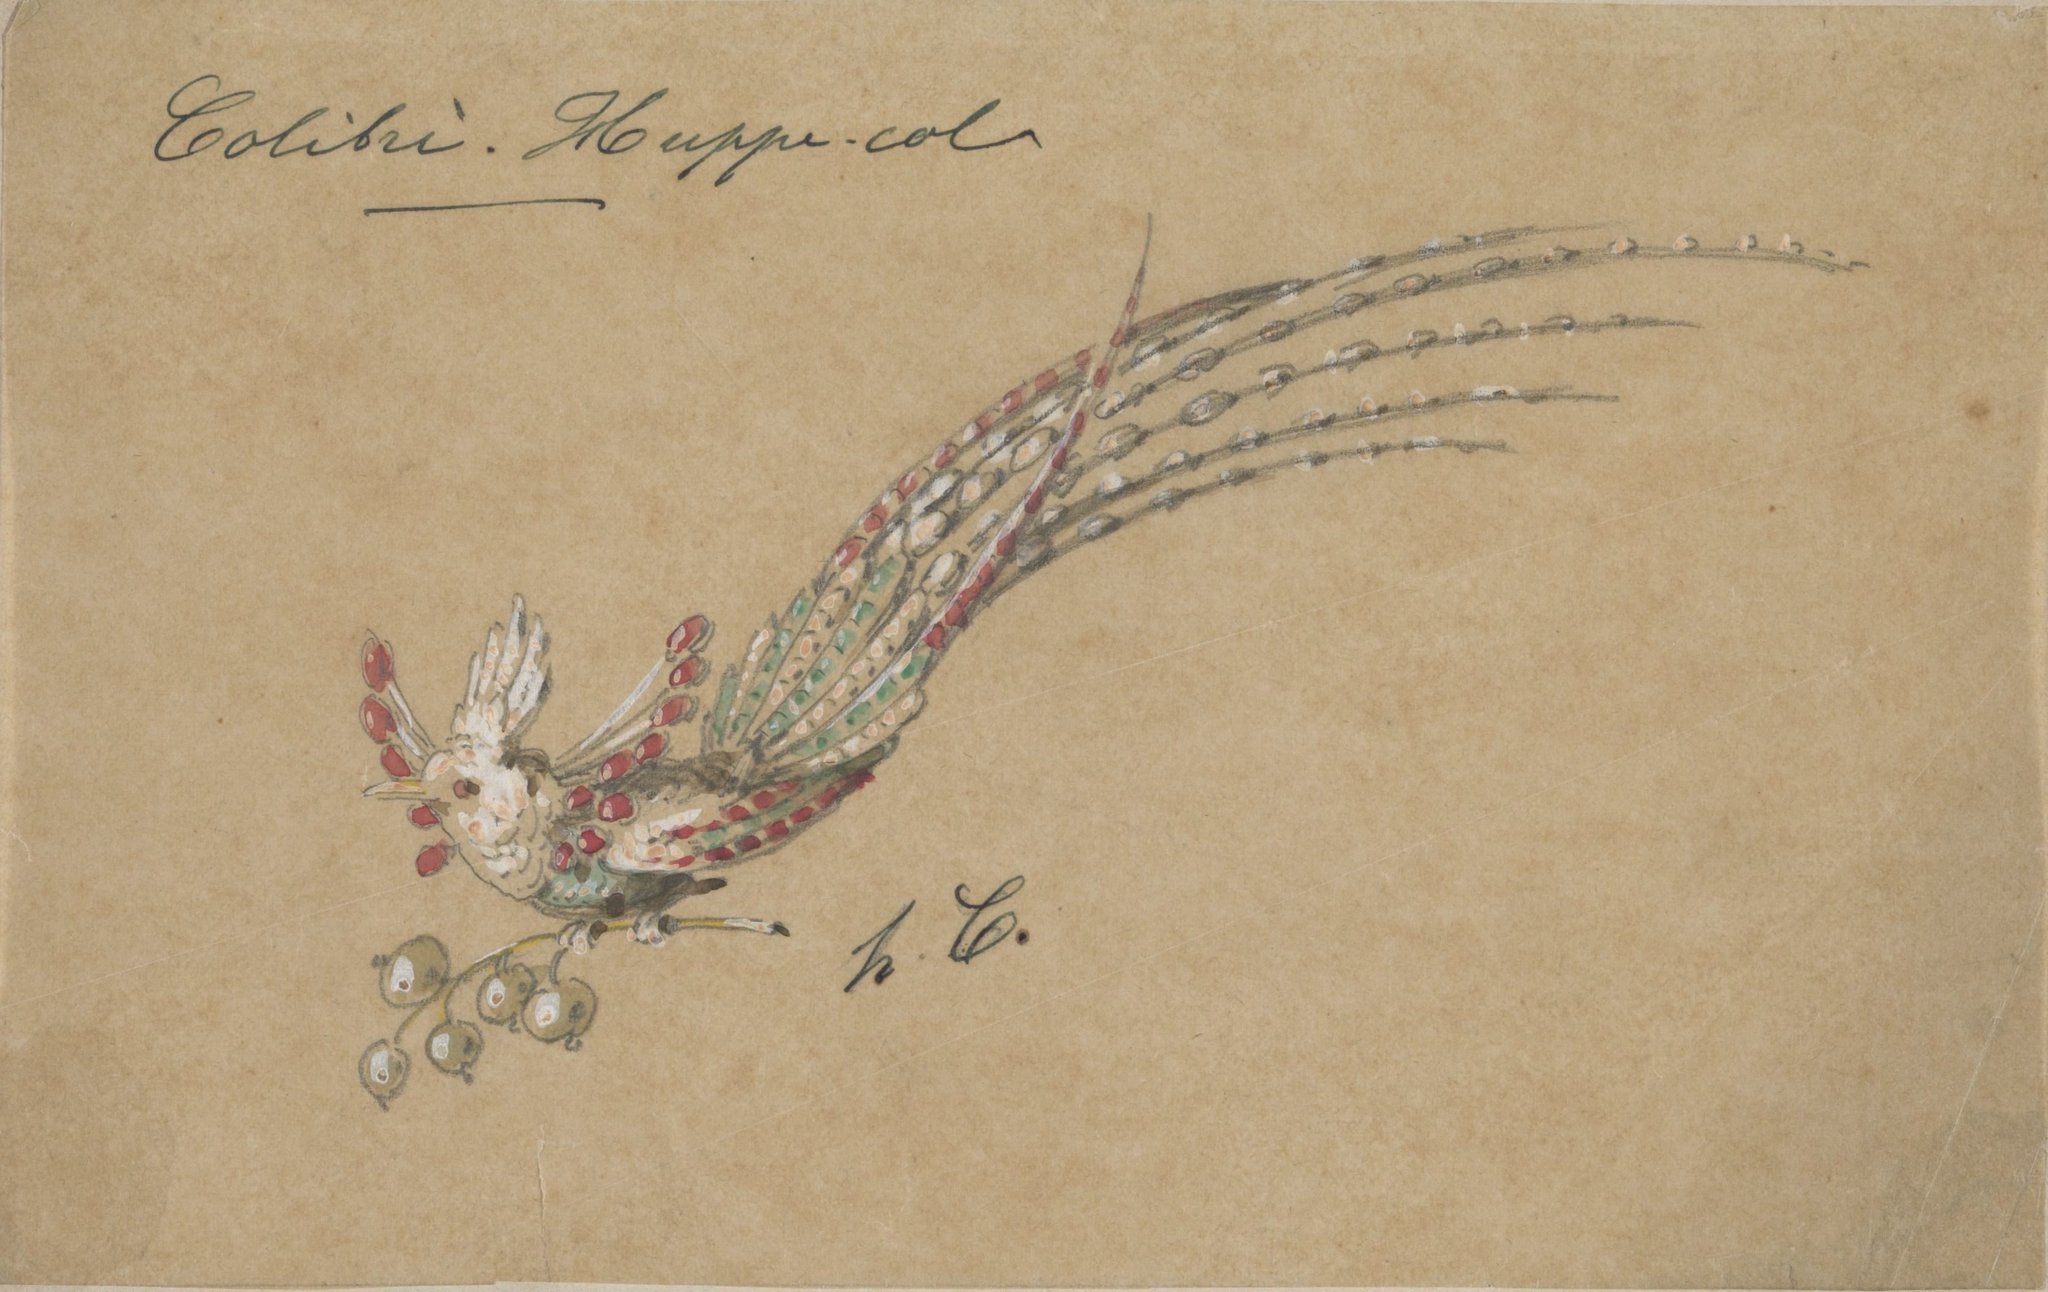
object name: design drawing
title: Design for a Jewel in the Shape of a Hummingbird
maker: henri cameré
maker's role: designer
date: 1864-1894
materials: paint, pencil, paper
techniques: brush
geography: paris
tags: other birds (with name), brooch, agraffe, clasp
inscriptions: inscription: ‘Cameré’, signature: ‘h.C.’, inscription: ‘Colobri Huppe-col’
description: The small South-American Tufted Coquette hummingbird served as the source of inspiration for this stunning jewel. The hummingbird is designed as an aigrette, a plume-shaped ornament worn by both men and women in their hair or on a hat. The colours white, red, and green probably refer to the choice for diamonds, rubies, and emeralds.